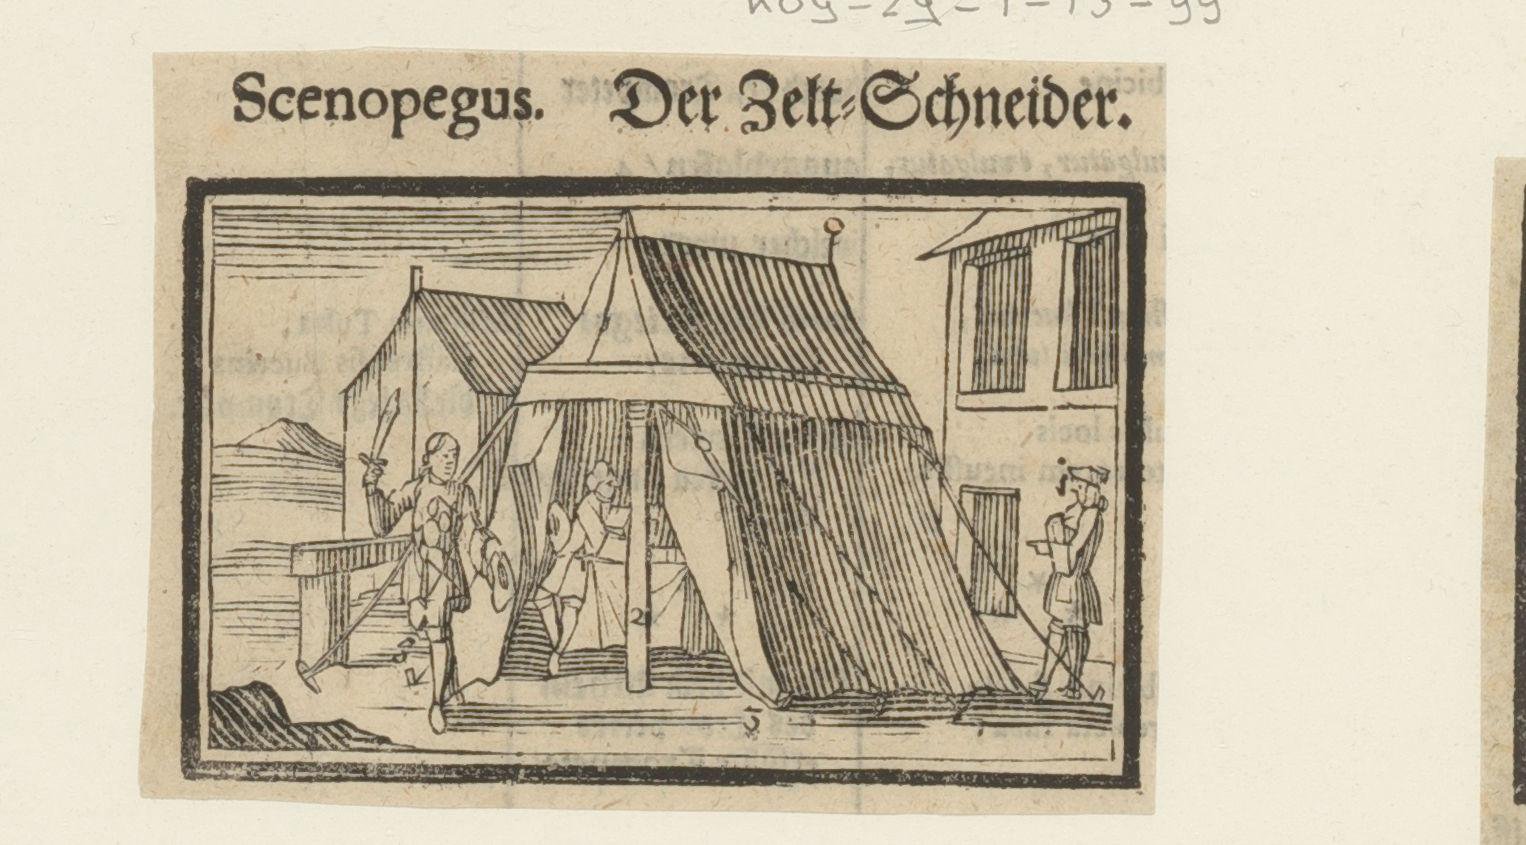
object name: print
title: Tentsnijder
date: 1719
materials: paper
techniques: letterpress printing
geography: nuremberg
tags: handicrafts, craftsman at work, tent-camp, warfare; military affairs, the soldier; the soldier's life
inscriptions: collector's mark: Lugt 1641, stamp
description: Prent uit: Comenius, Johannes Amosius. Orbis sensualium picti pars prima (...). Neurenberg: Martin Endter, 1719, dl. 2, p. 298. Prent eerder gebruikt in: Comenius, Johannes Amosius. Orbis Sensualium Picti denuo aucti Pars Secunda (...). Neurenberg: Martin Endter, 1730, dl. 2.